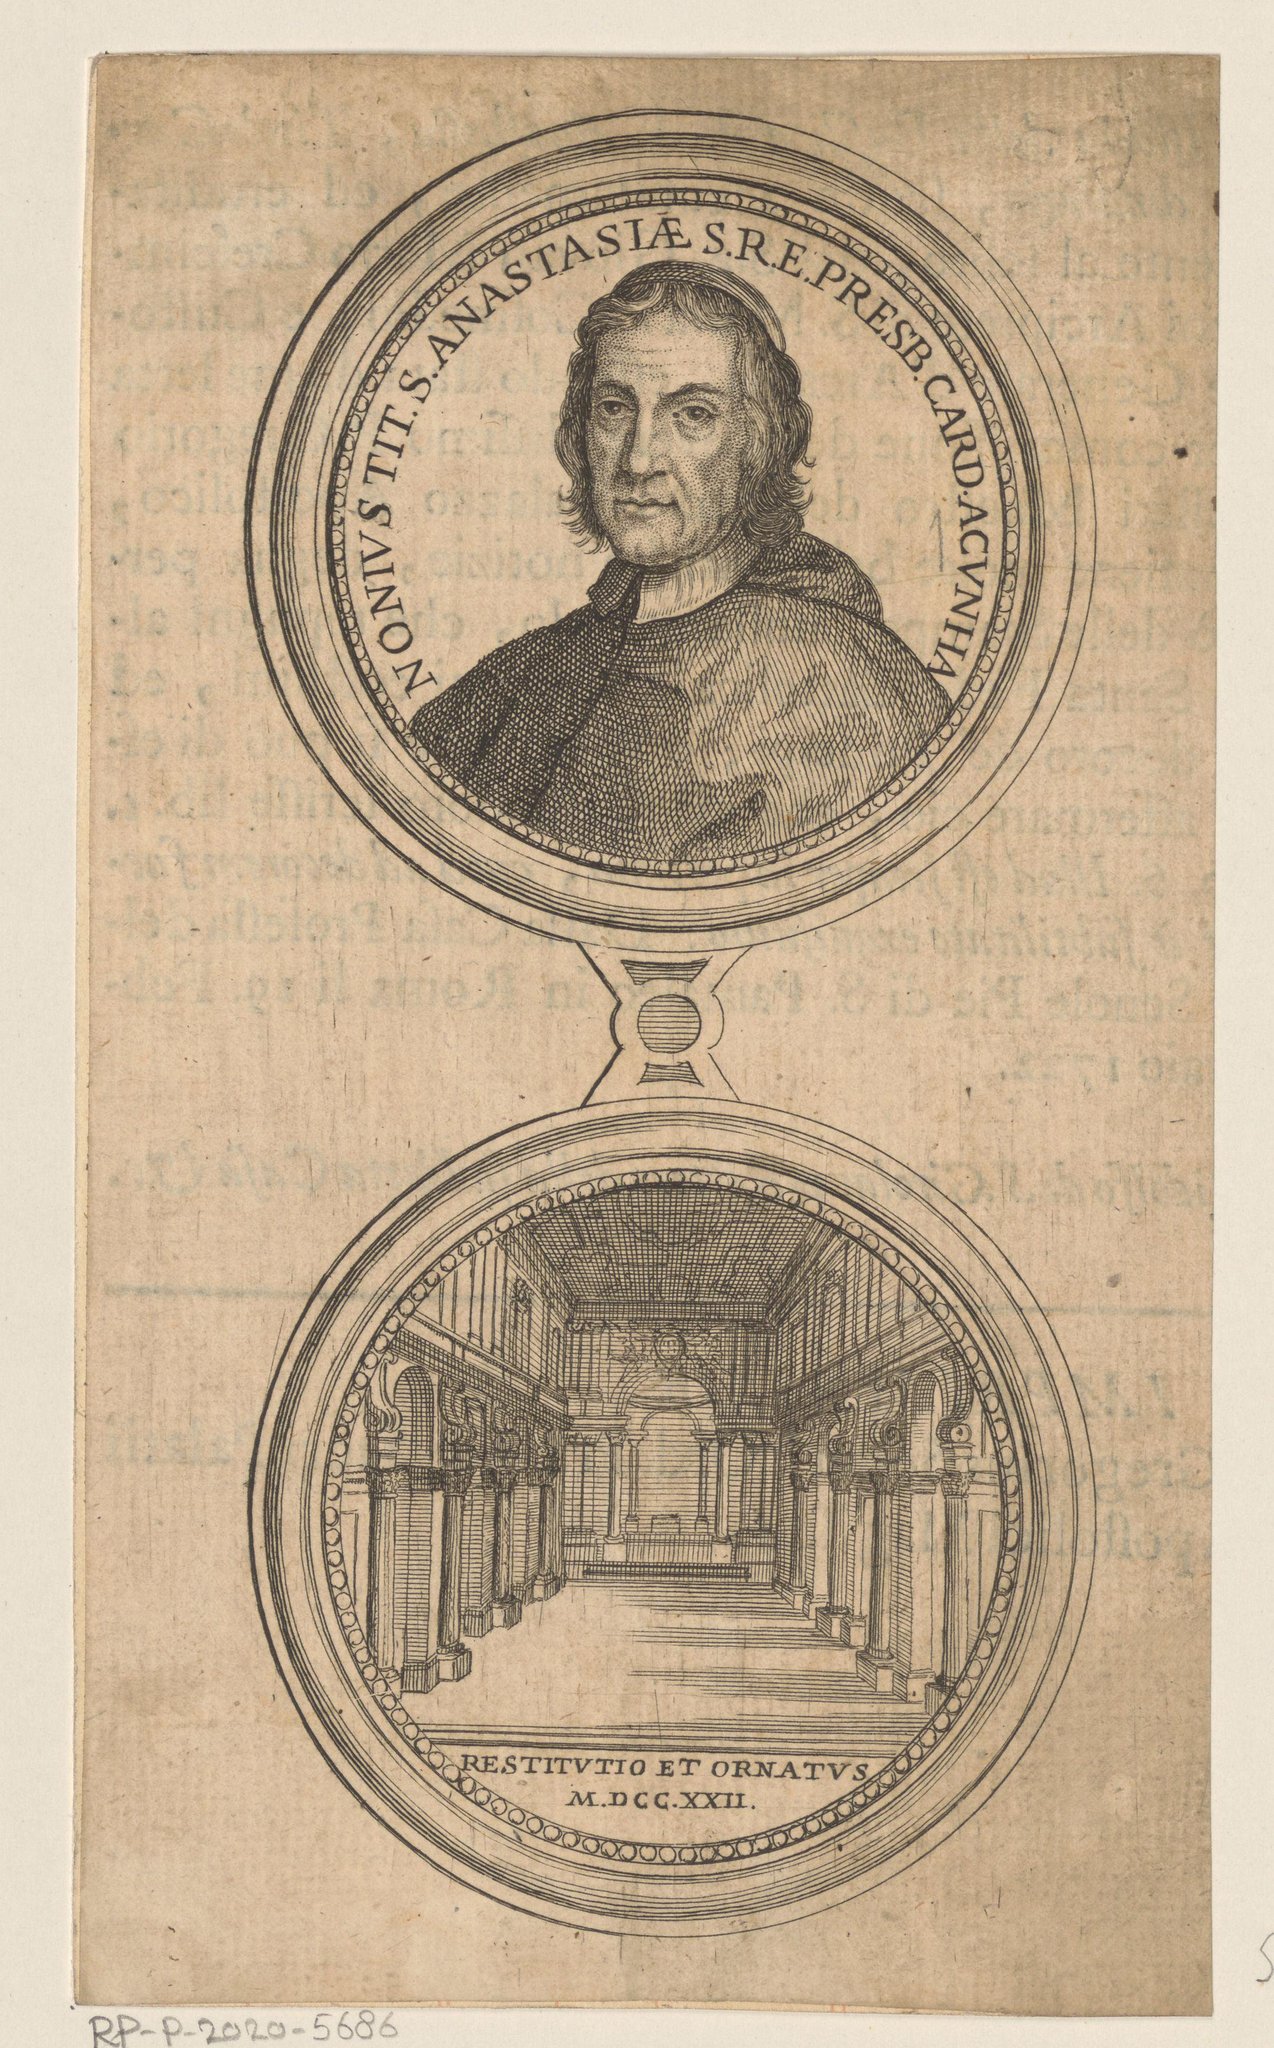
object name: print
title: Portret van Nuno da Cunha e Ataíde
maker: Anonymous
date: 1722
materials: paper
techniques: engraving, etching, letterpress printing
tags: historical persons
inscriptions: date